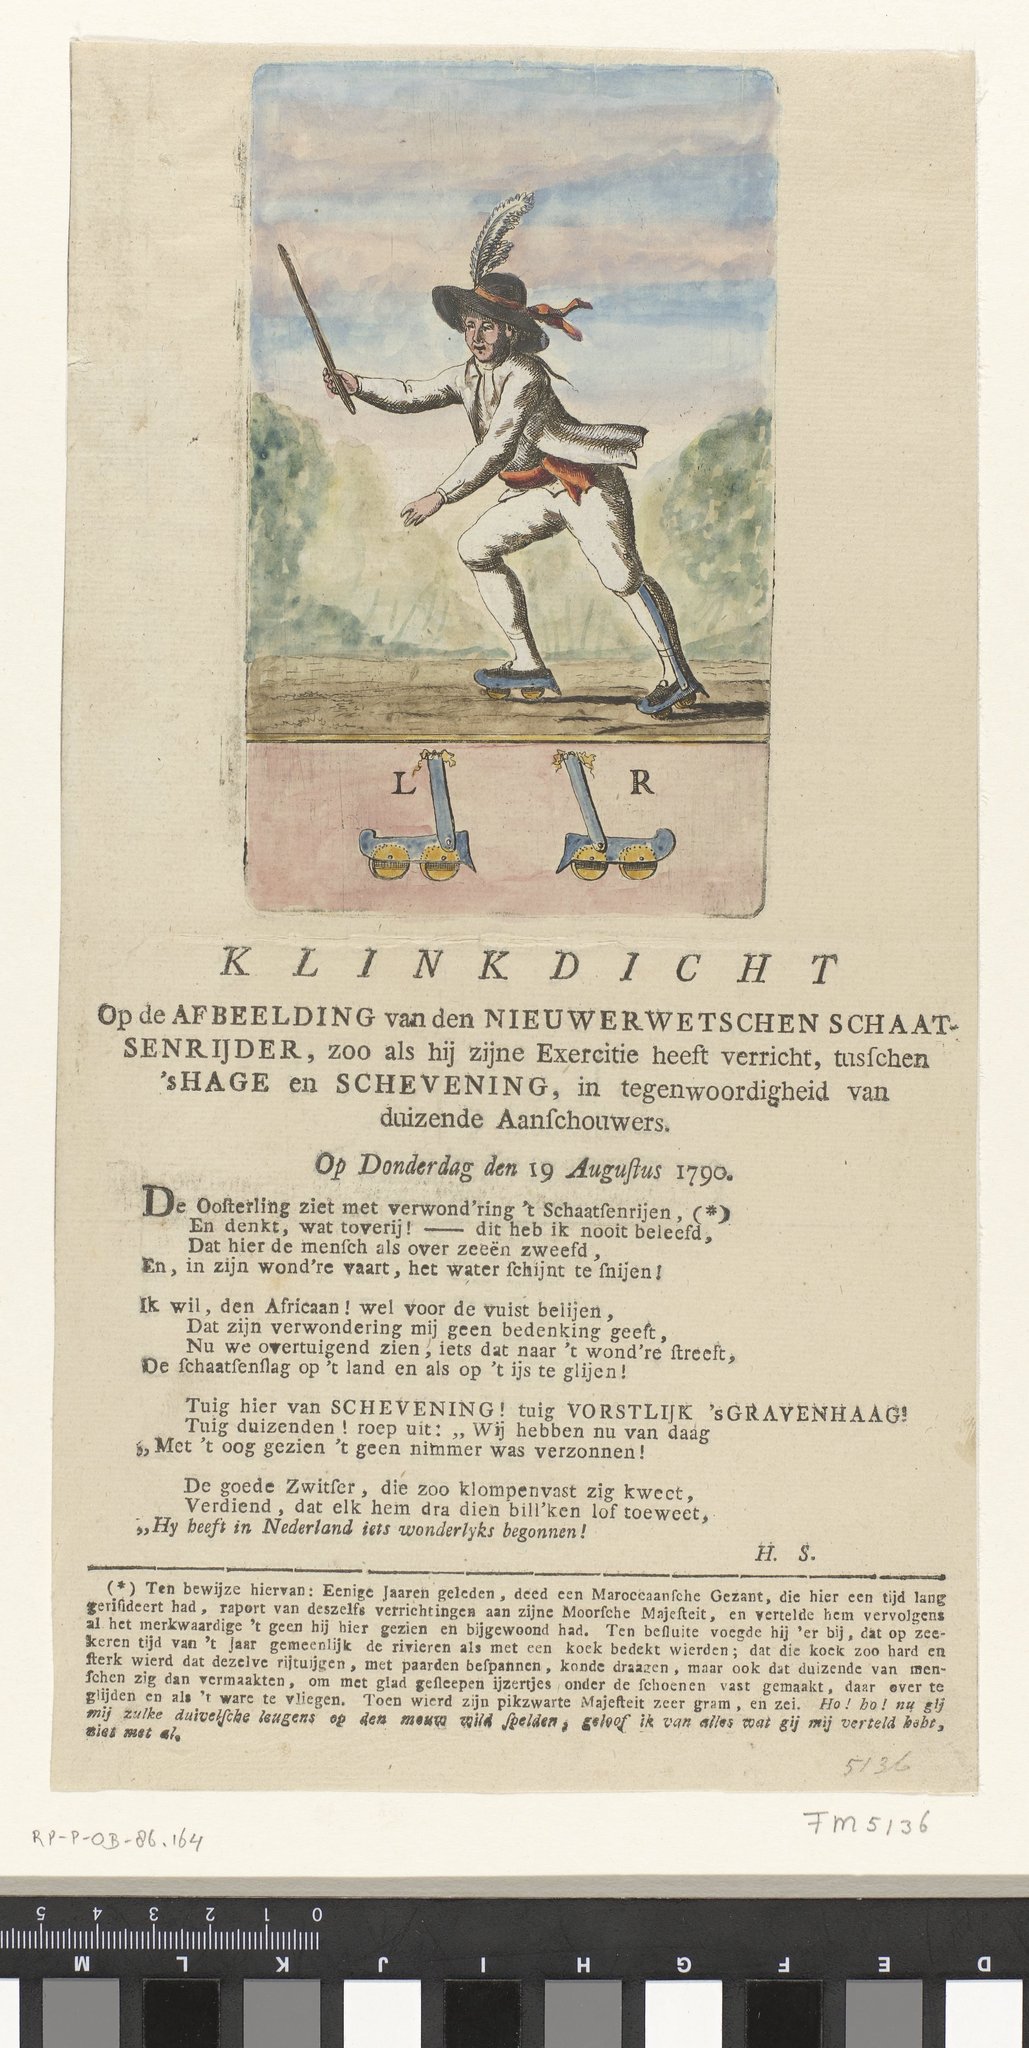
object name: print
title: Afbeelding van den Nieuwerwetschen Schaatsenrijder, zoo als hij zijne Exercitie heeft verricht, tusschen 'sHage en Schevening, in tegenwoordigheid van duizende Aanschouwers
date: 1790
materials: paper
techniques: etching, hand coloring, letterpress printing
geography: northern netherlands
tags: roller-skating, roller-skates, the hague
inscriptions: collector's mark: Lugt 2228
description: De Zwitserse rolschaatser die op 19 augustus 1790 een demonstratie van het rolschaatsen gaf, op de weg tussen Den Haag en Scheveningen. Met details van de linker en rechter rolschaats. Op het blad onder de plaat een klinkdicht in vier coupletten en in een voetnoot een verhaal over de Marokkaanse gezant.